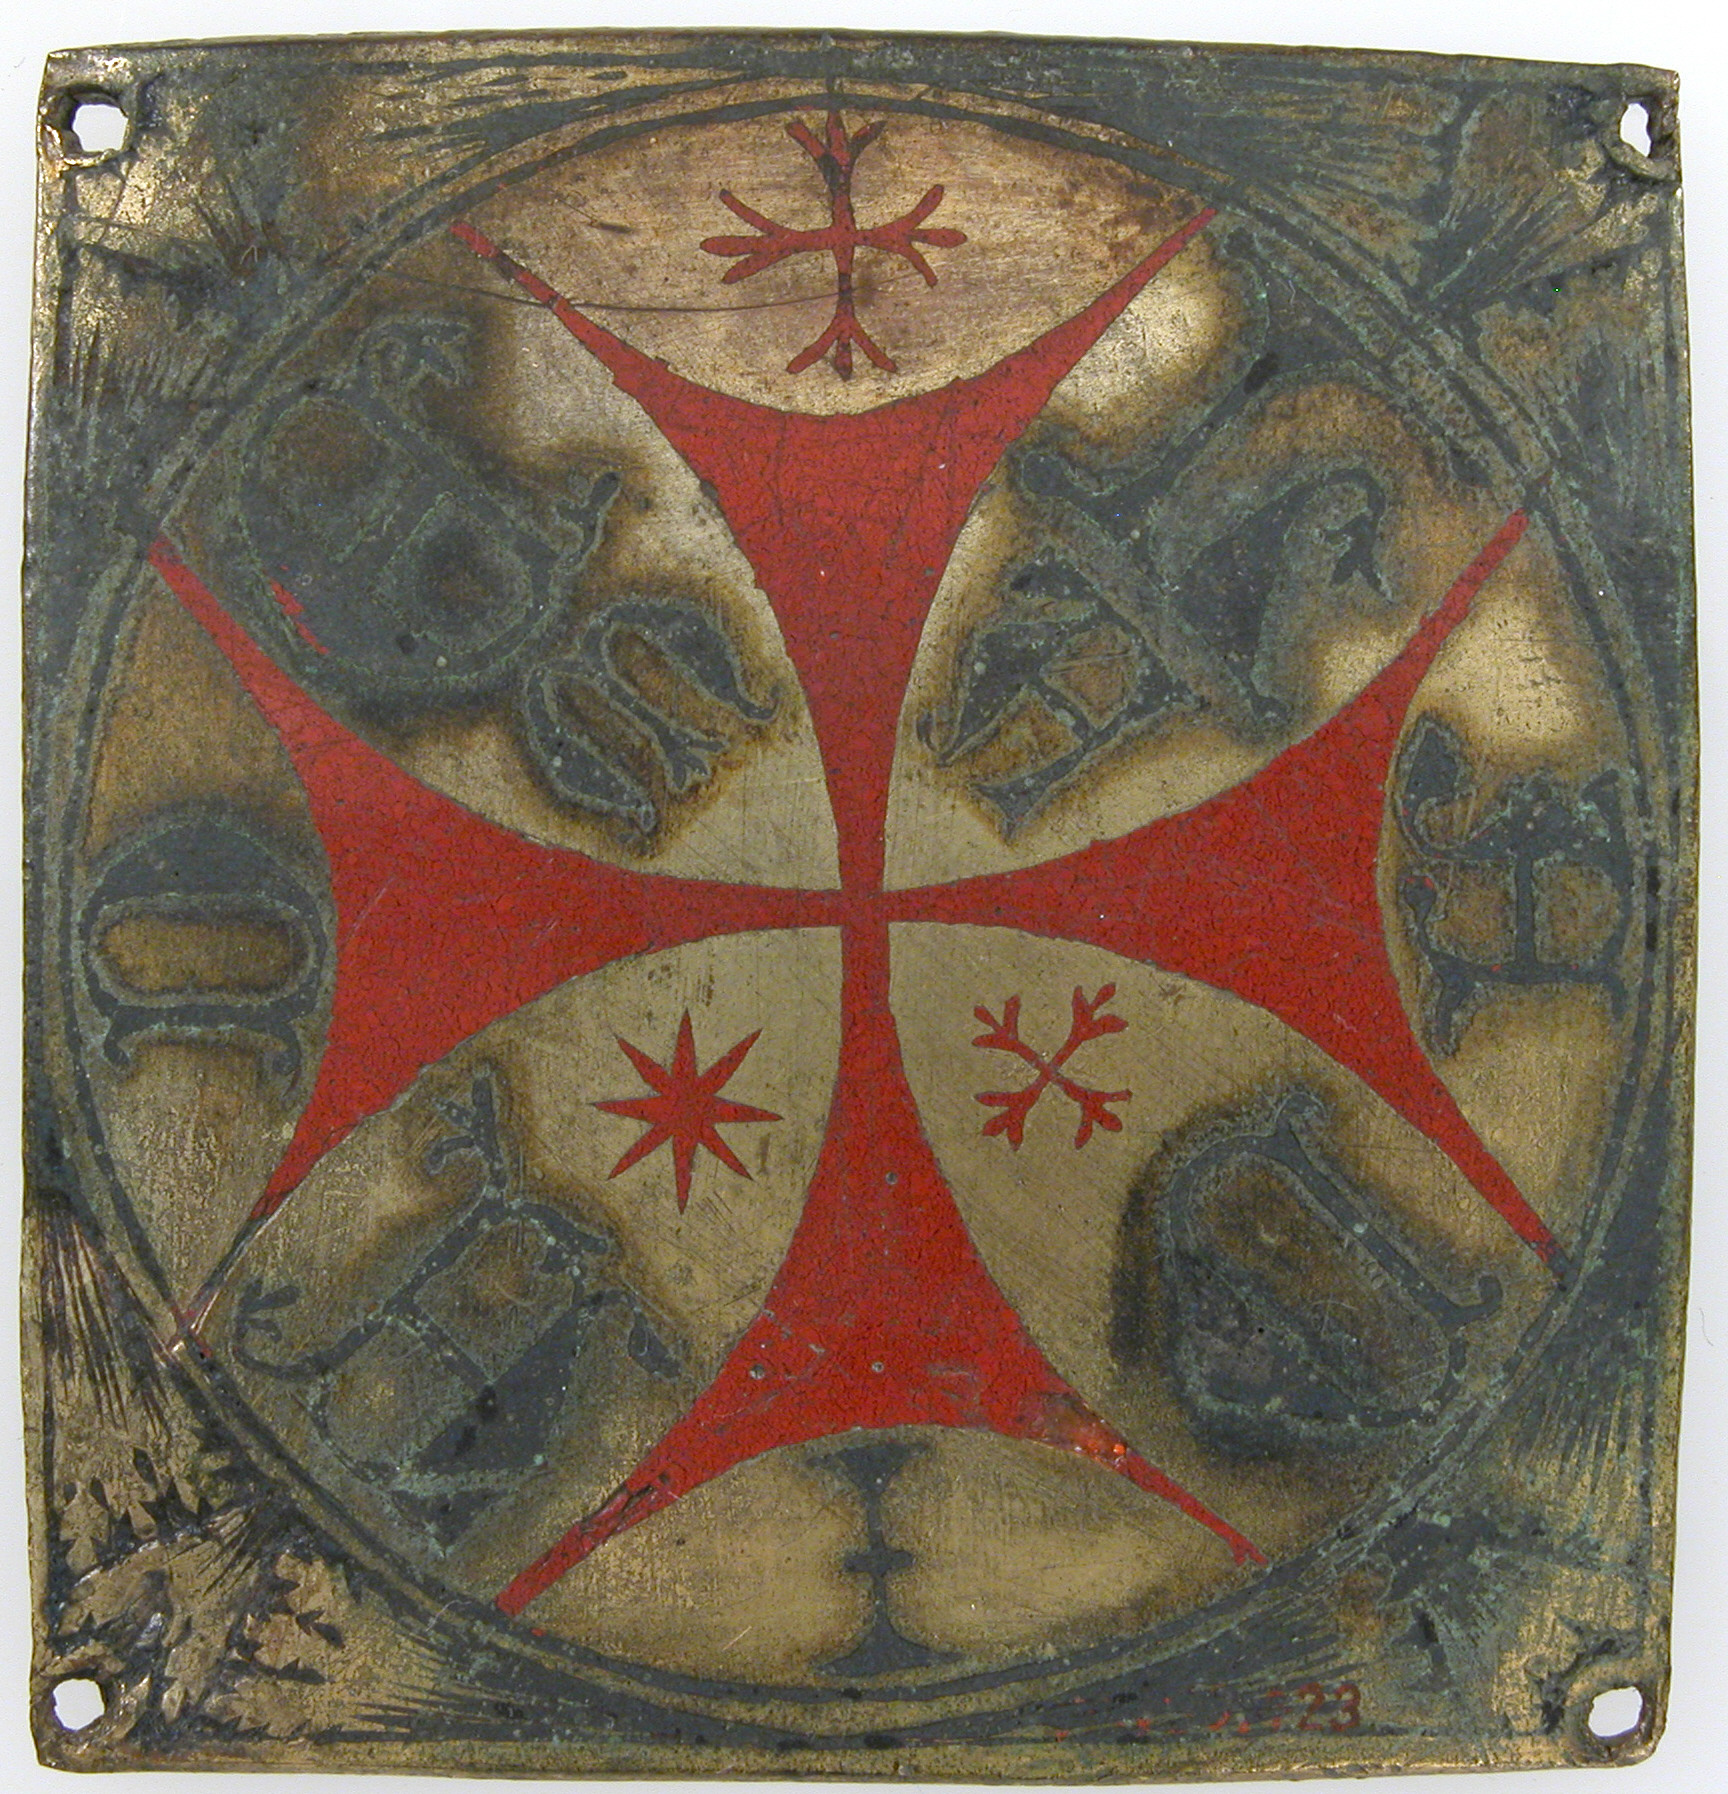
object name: plaque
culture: german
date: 1101-1300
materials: copper, enamel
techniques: enamel